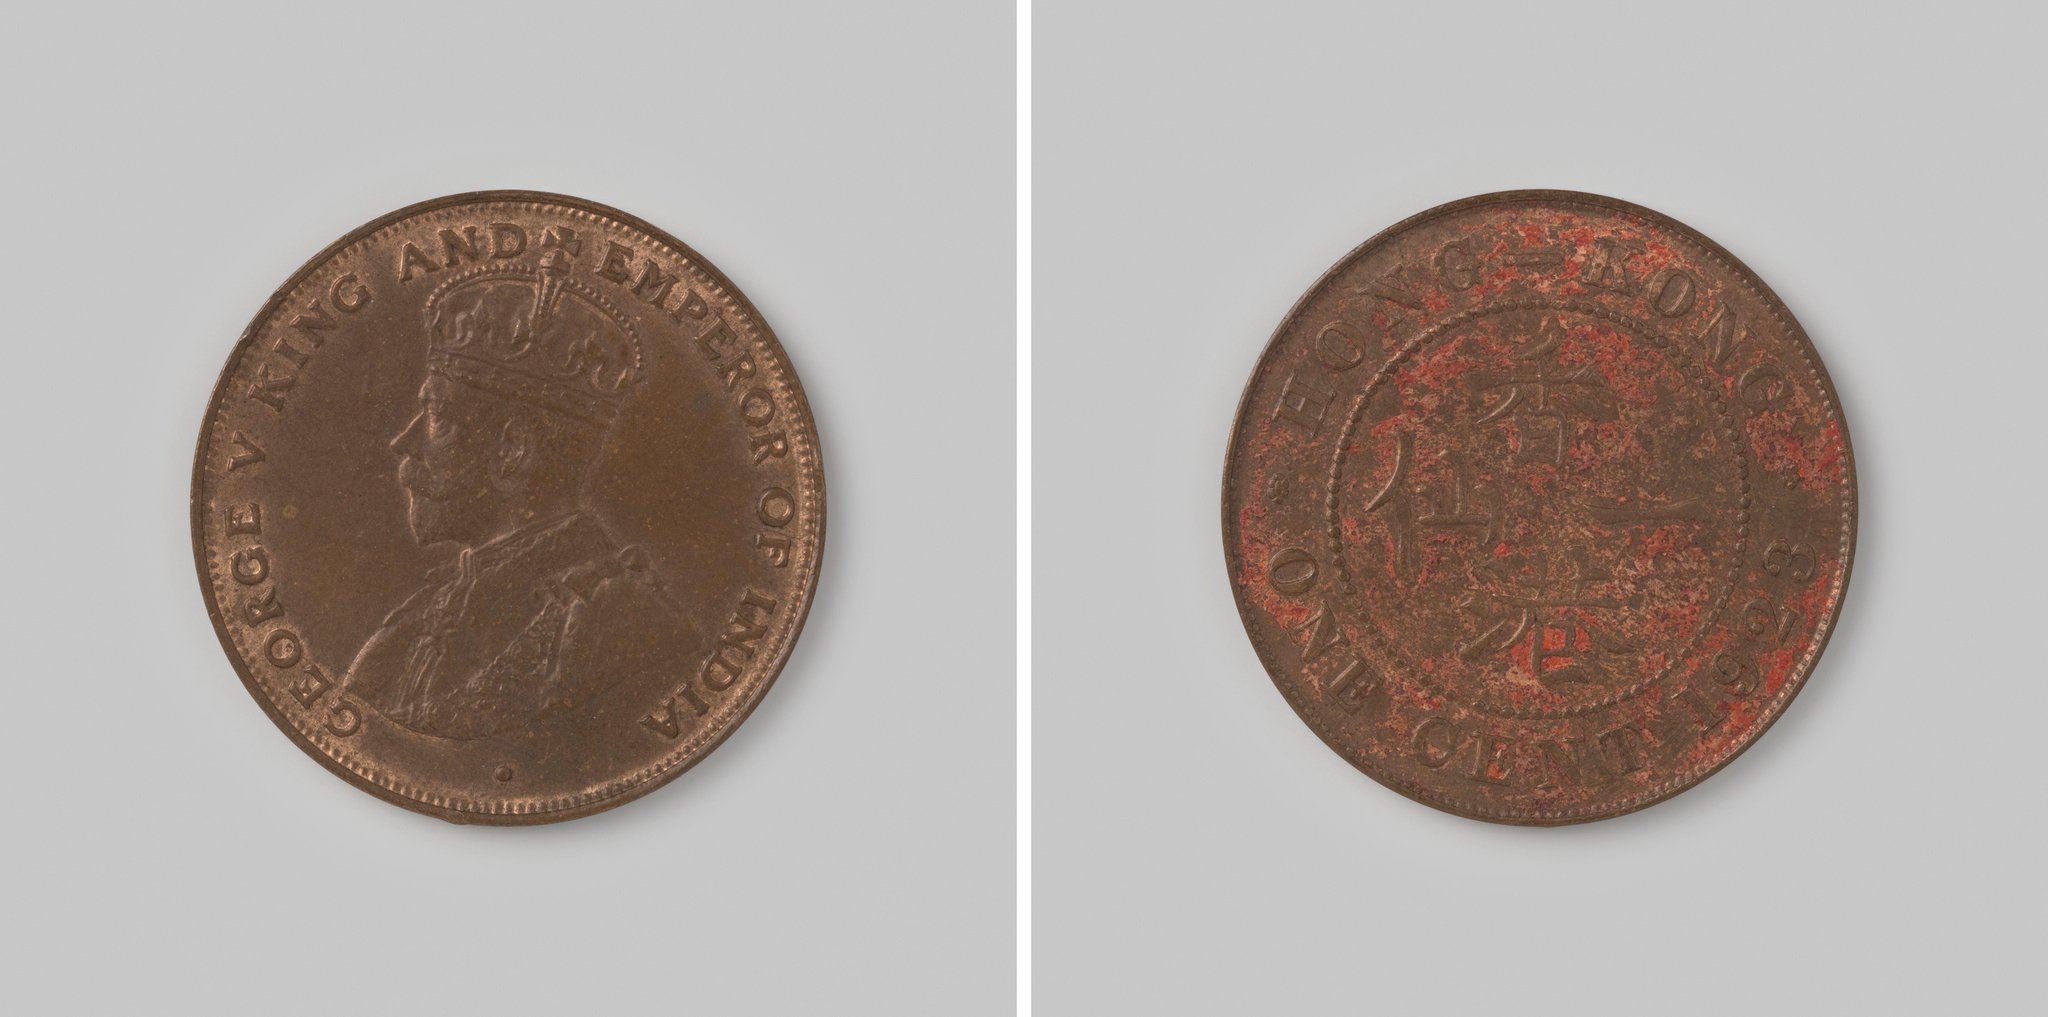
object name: coin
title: Hongkong, George V, cent, 1923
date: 1923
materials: bronze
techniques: striking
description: Bronzen munt. Voorzijde: gekroond borstbeeld van de keizer en koning George V naar links. Keerzijde: in het omschrift waarde-aanduiding: one cent met rechts daarvan jaartal. Gladde rand.